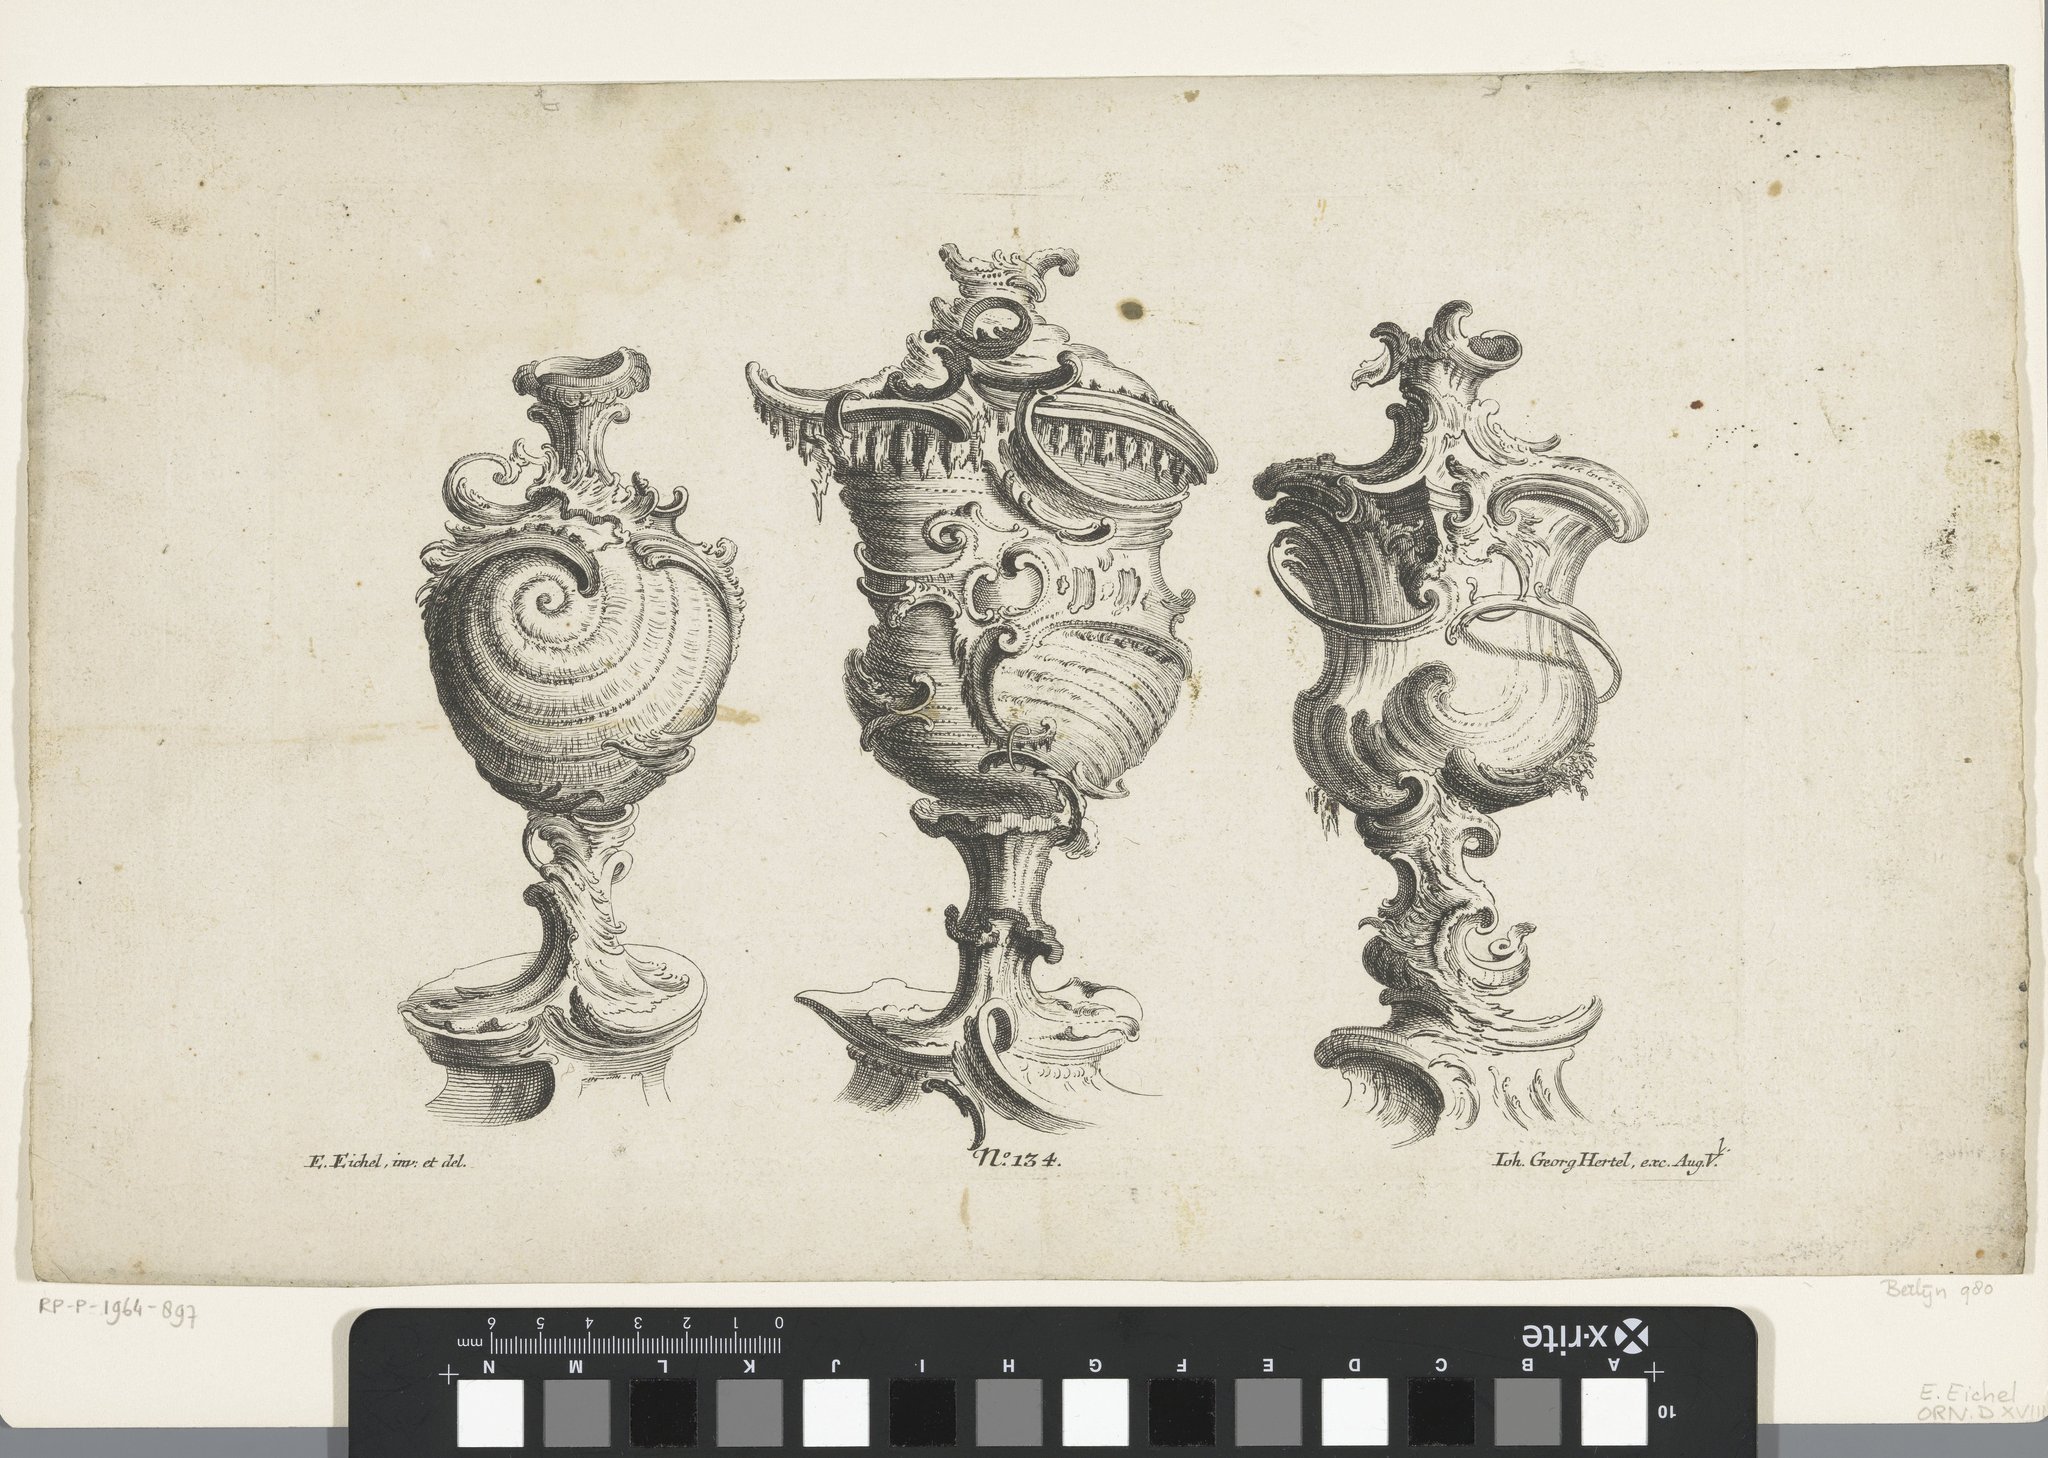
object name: ornament print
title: Drie vazen met rocailles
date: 1727-1775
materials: paper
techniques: etching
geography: augsburg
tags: rocaille ornament, vase ~ ornament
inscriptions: collector's mark: Lugt 2760, collector's mark: Lugt 2228